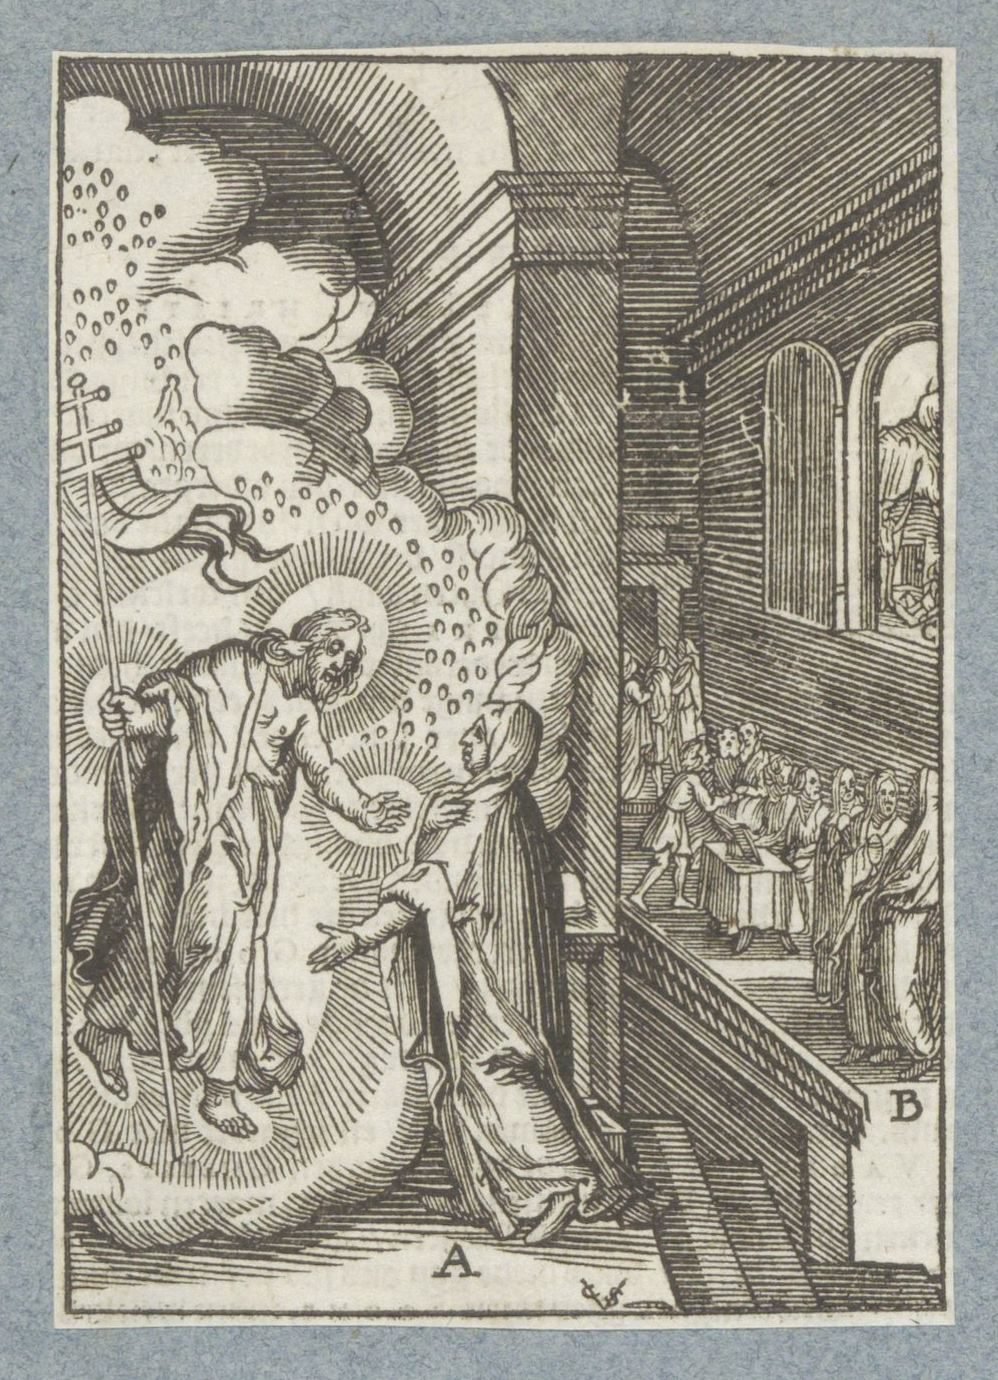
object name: album leaf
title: Christus verschijnt aan Maria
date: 1629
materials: paper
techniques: letterpress printing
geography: amsterdam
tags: the holy women (the three maries) on their way to or at the tomb, to anoint christ's body, christ, perhaps dressed as a pilgrim, appearing to his mother, who is usually shown praying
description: De prent is afkomstig uit een van de uitgaven van P.J. Paets uit Amsterdam. De prent wordt voor het eerst gebruikt in: Der Zielen Lust-hof. Leuven, I.Jacbosz voor P.J. Paets [= Amsterdam, P.J. Paets], 1629. De voorstelling is gekopieerd naar een prent van Antonie II Wierix voor: Nadal, Jerónimo. Evangelicae Historiae Imagines. Antwerpen, M. Nutius, 1593.